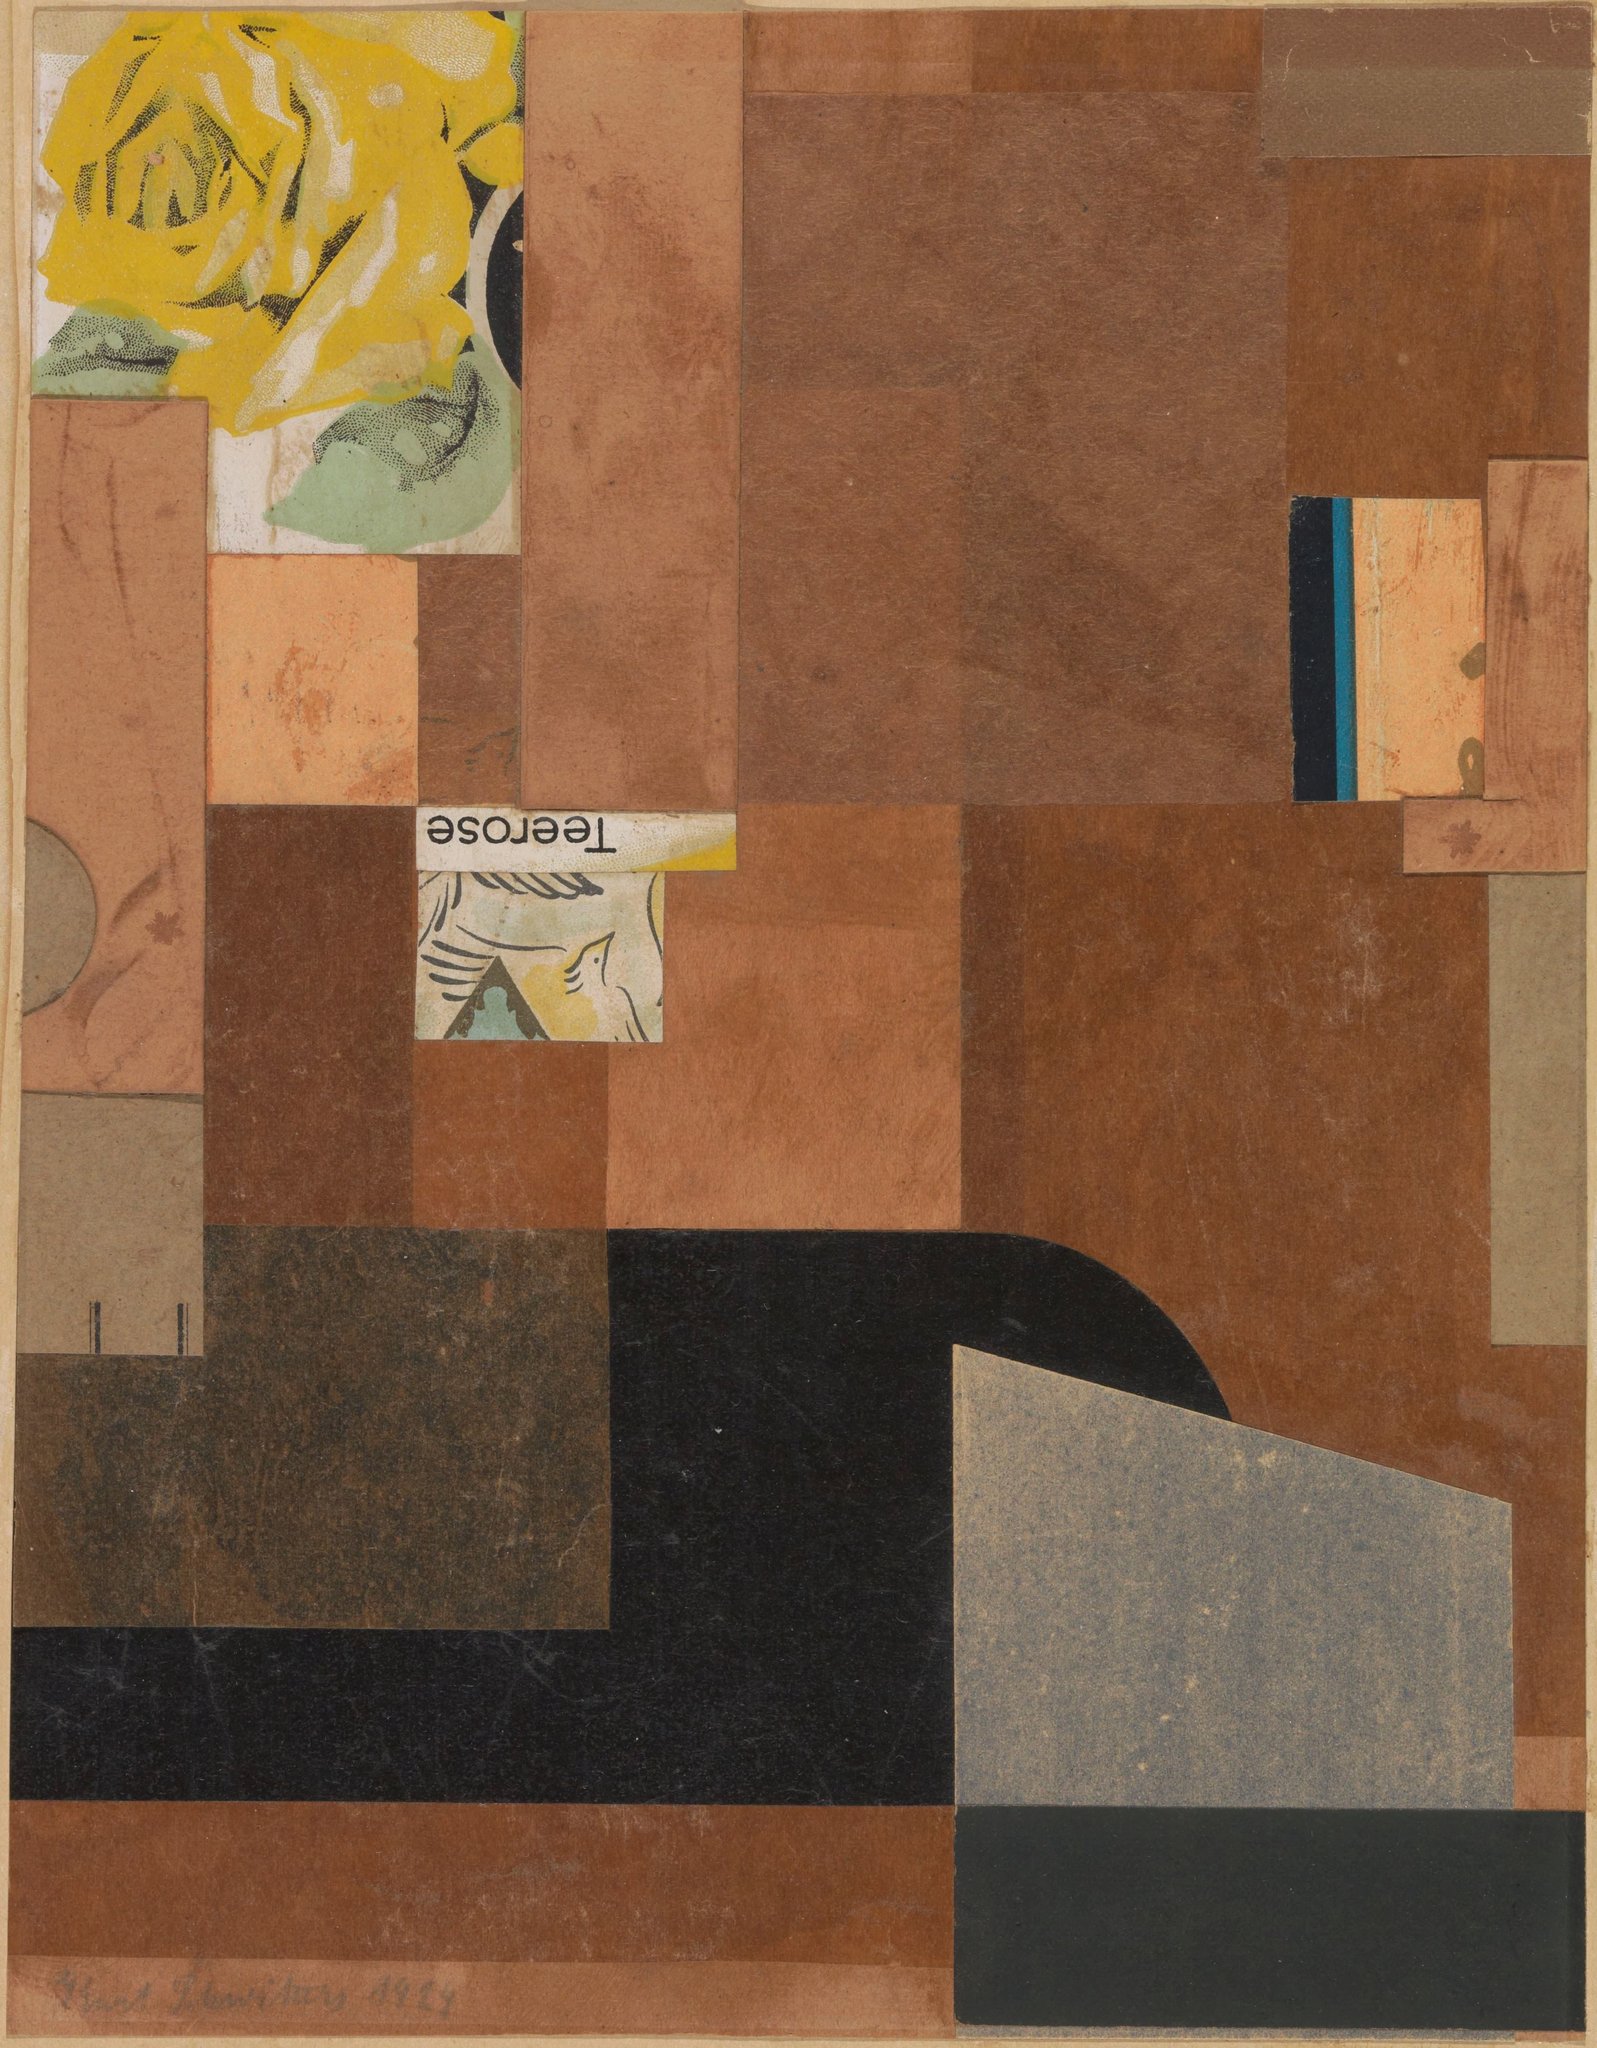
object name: collage visual work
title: Tea Rose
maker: kurt schwitters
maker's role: painter, print maker, sculptor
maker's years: 1887-1948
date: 1924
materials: paper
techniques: collage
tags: abstract, non-representational art, flowers: rose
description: This collage is made of all kinds of scraps of paper that Kurt Schwitters gathered from the streets. He took suitcases full of scavenged trash and objets trouvés with him when he travelled. In the abstract composition of brown, grey, pink and black angular planes, he attached an illustration of a rose. Another fragment identifies it as a tea rose. Such a bit of reality is a light-hearted counterbalance to the sober abstract composition.